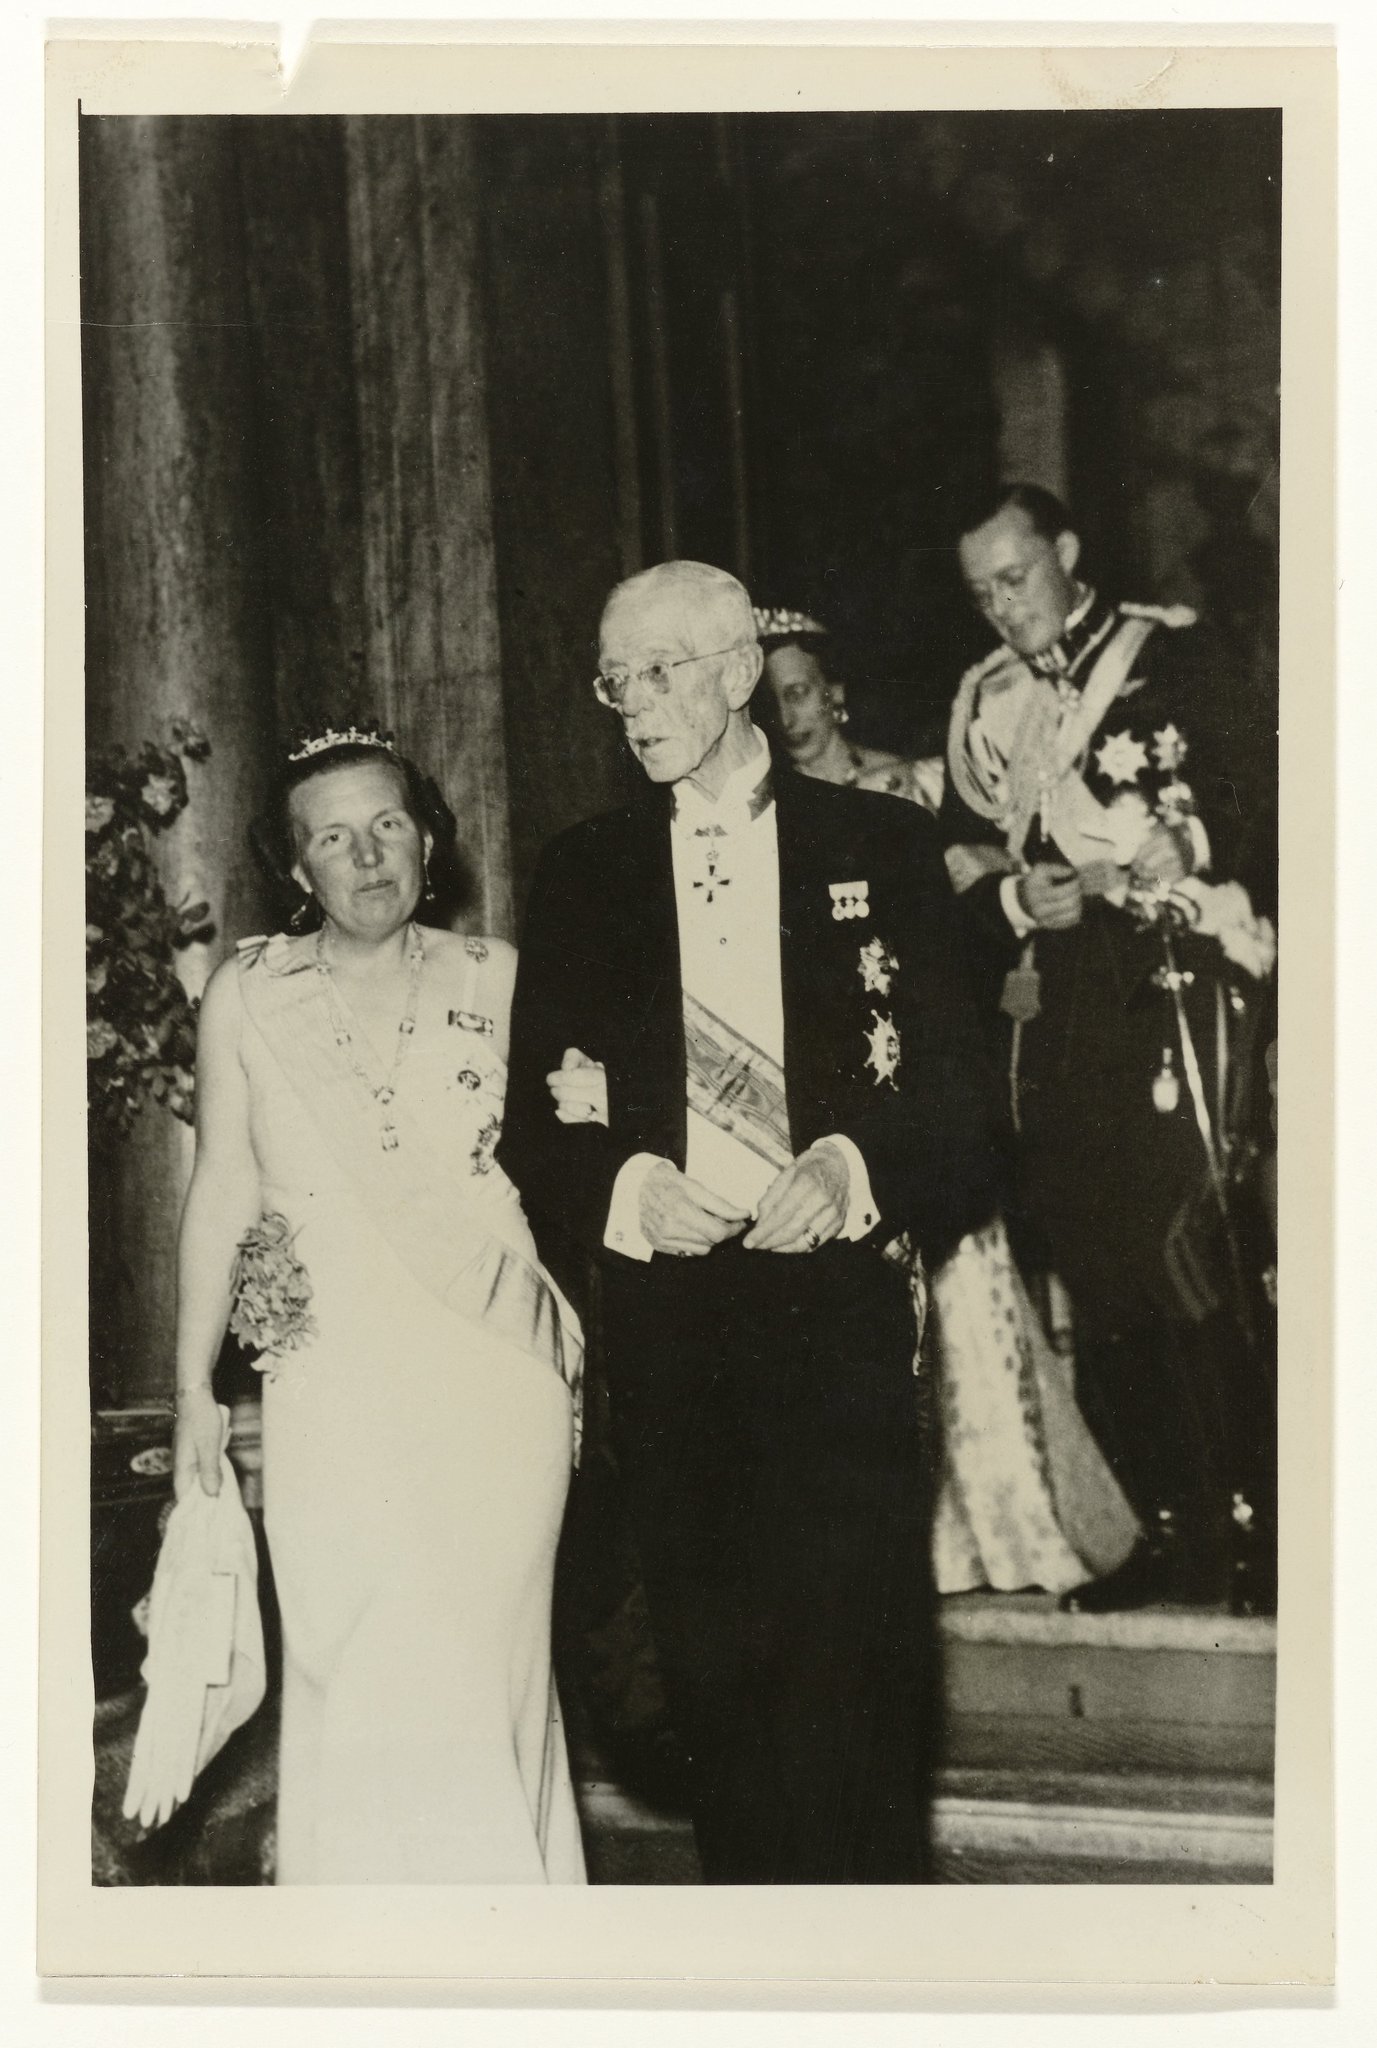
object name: photograph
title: Leden van koninklijk huis en koning Gustaaf van Zweden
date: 1945-1946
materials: photographic support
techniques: photography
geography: karlberg palace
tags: utrecht, bernhard (prins der nederlanden), the hague, juliana of the netherlands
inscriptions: inscription, stamp: ‘COPYRIGHT / 'ANEFO' / ALGEMEEN NEDERLANDSCH FOTOBUREAU’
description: Prinses Juliana, prins Bernhard en koning Gustaaf van Zweden tijdens het galadiner aan het Zweedse Hof.